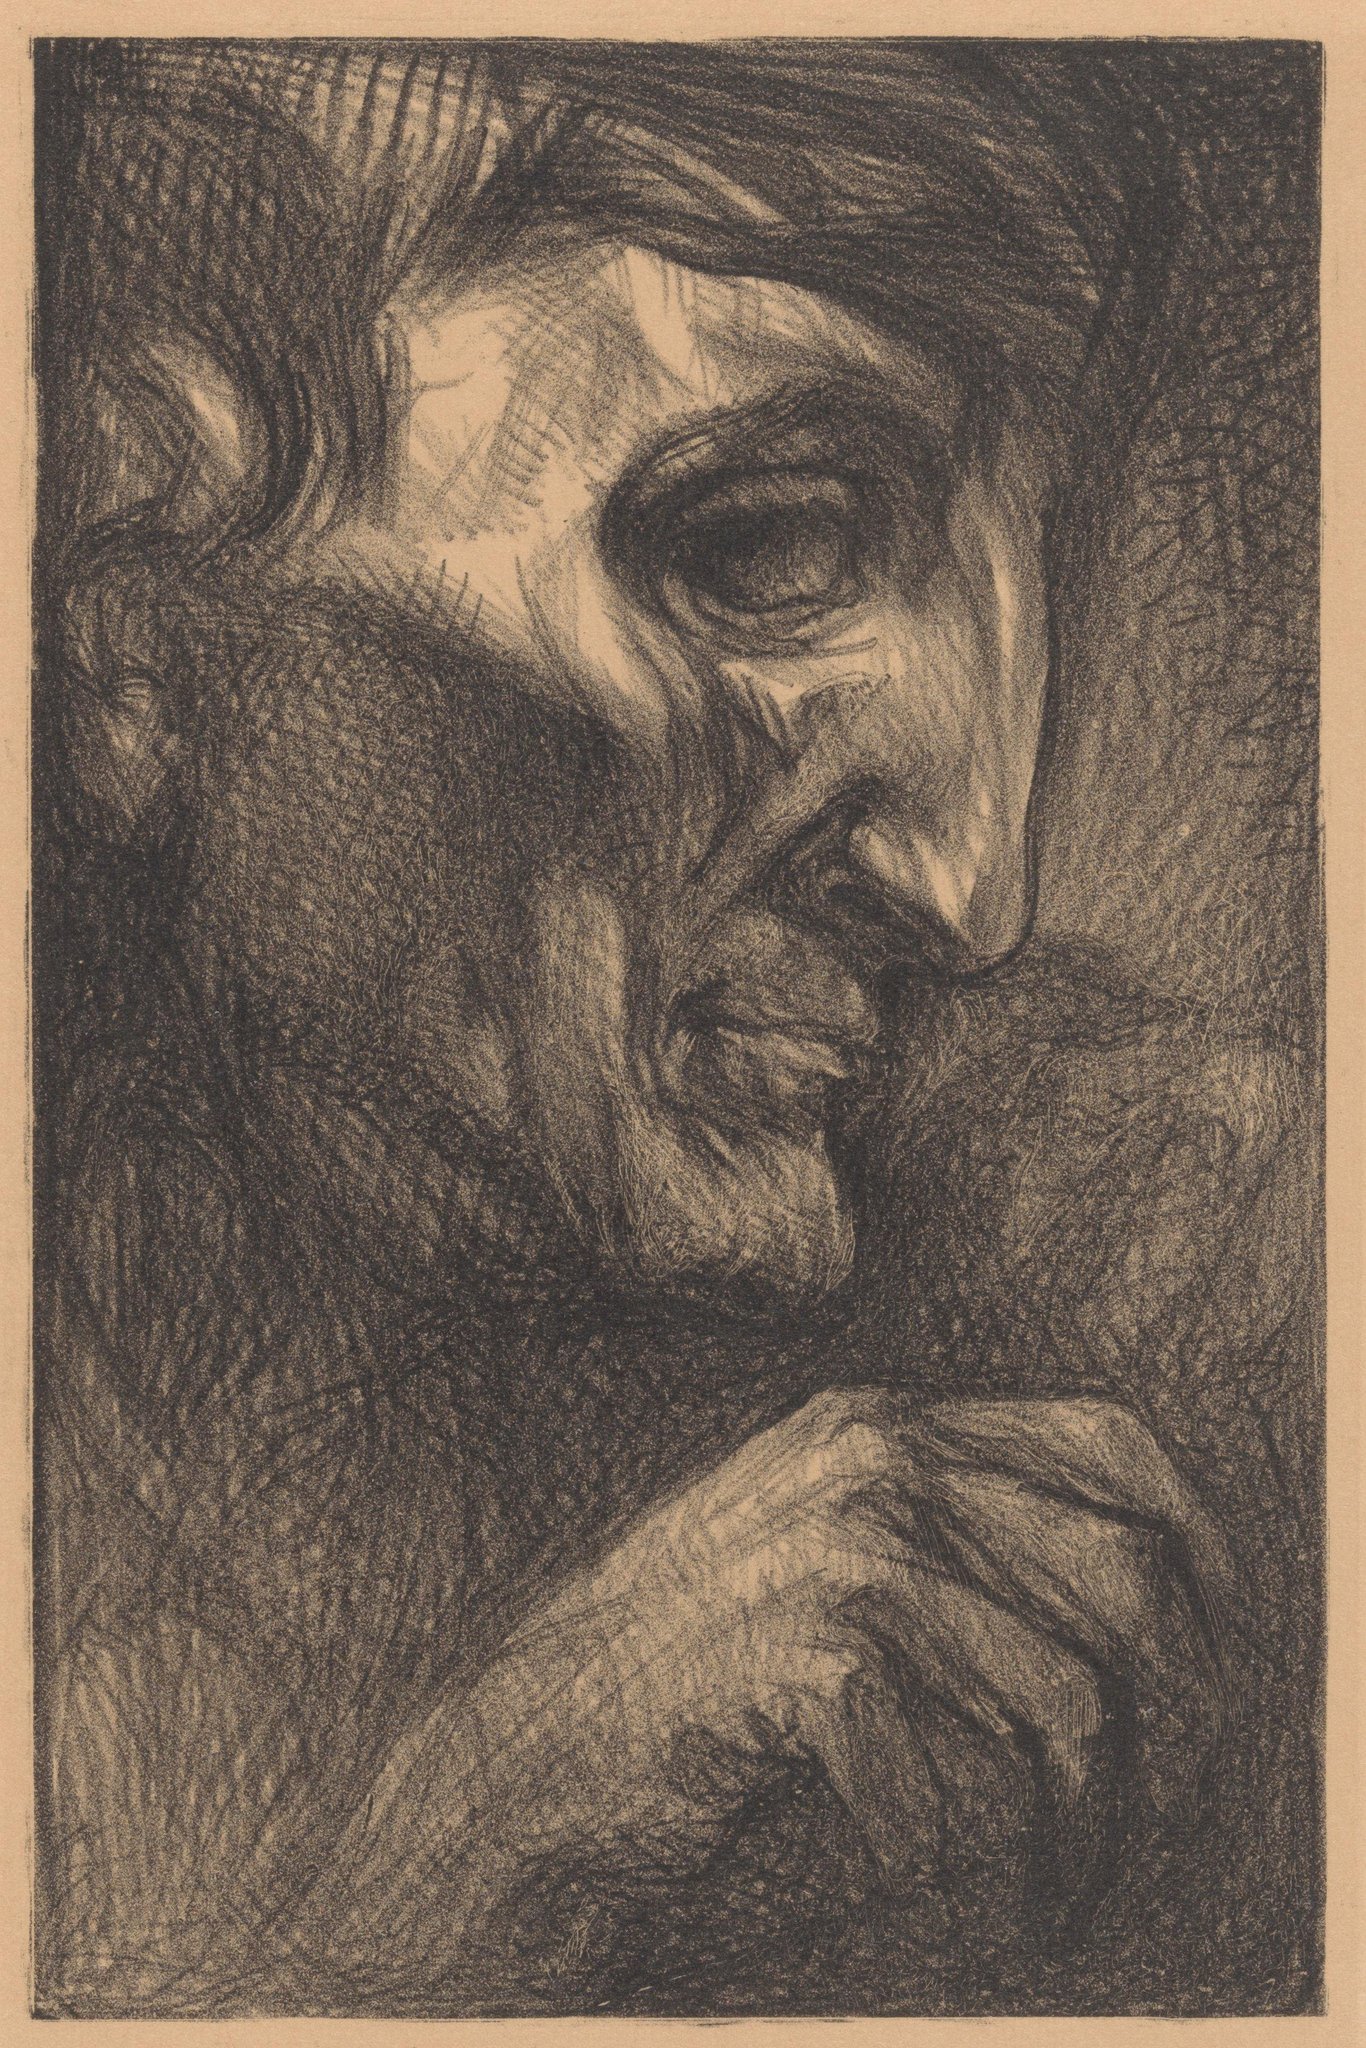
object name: print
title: Hoofd en hand van een man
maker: johannes josephus aarts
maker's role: draughtsman, print maker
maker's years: 1871-1934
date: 1881-1931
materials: paper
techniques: lithograph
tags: head (human) (+ sideview, profile), hand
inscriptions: collector's mark: Lugt 2228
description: Het hoofd en de hand van een man, in profiel gezien.